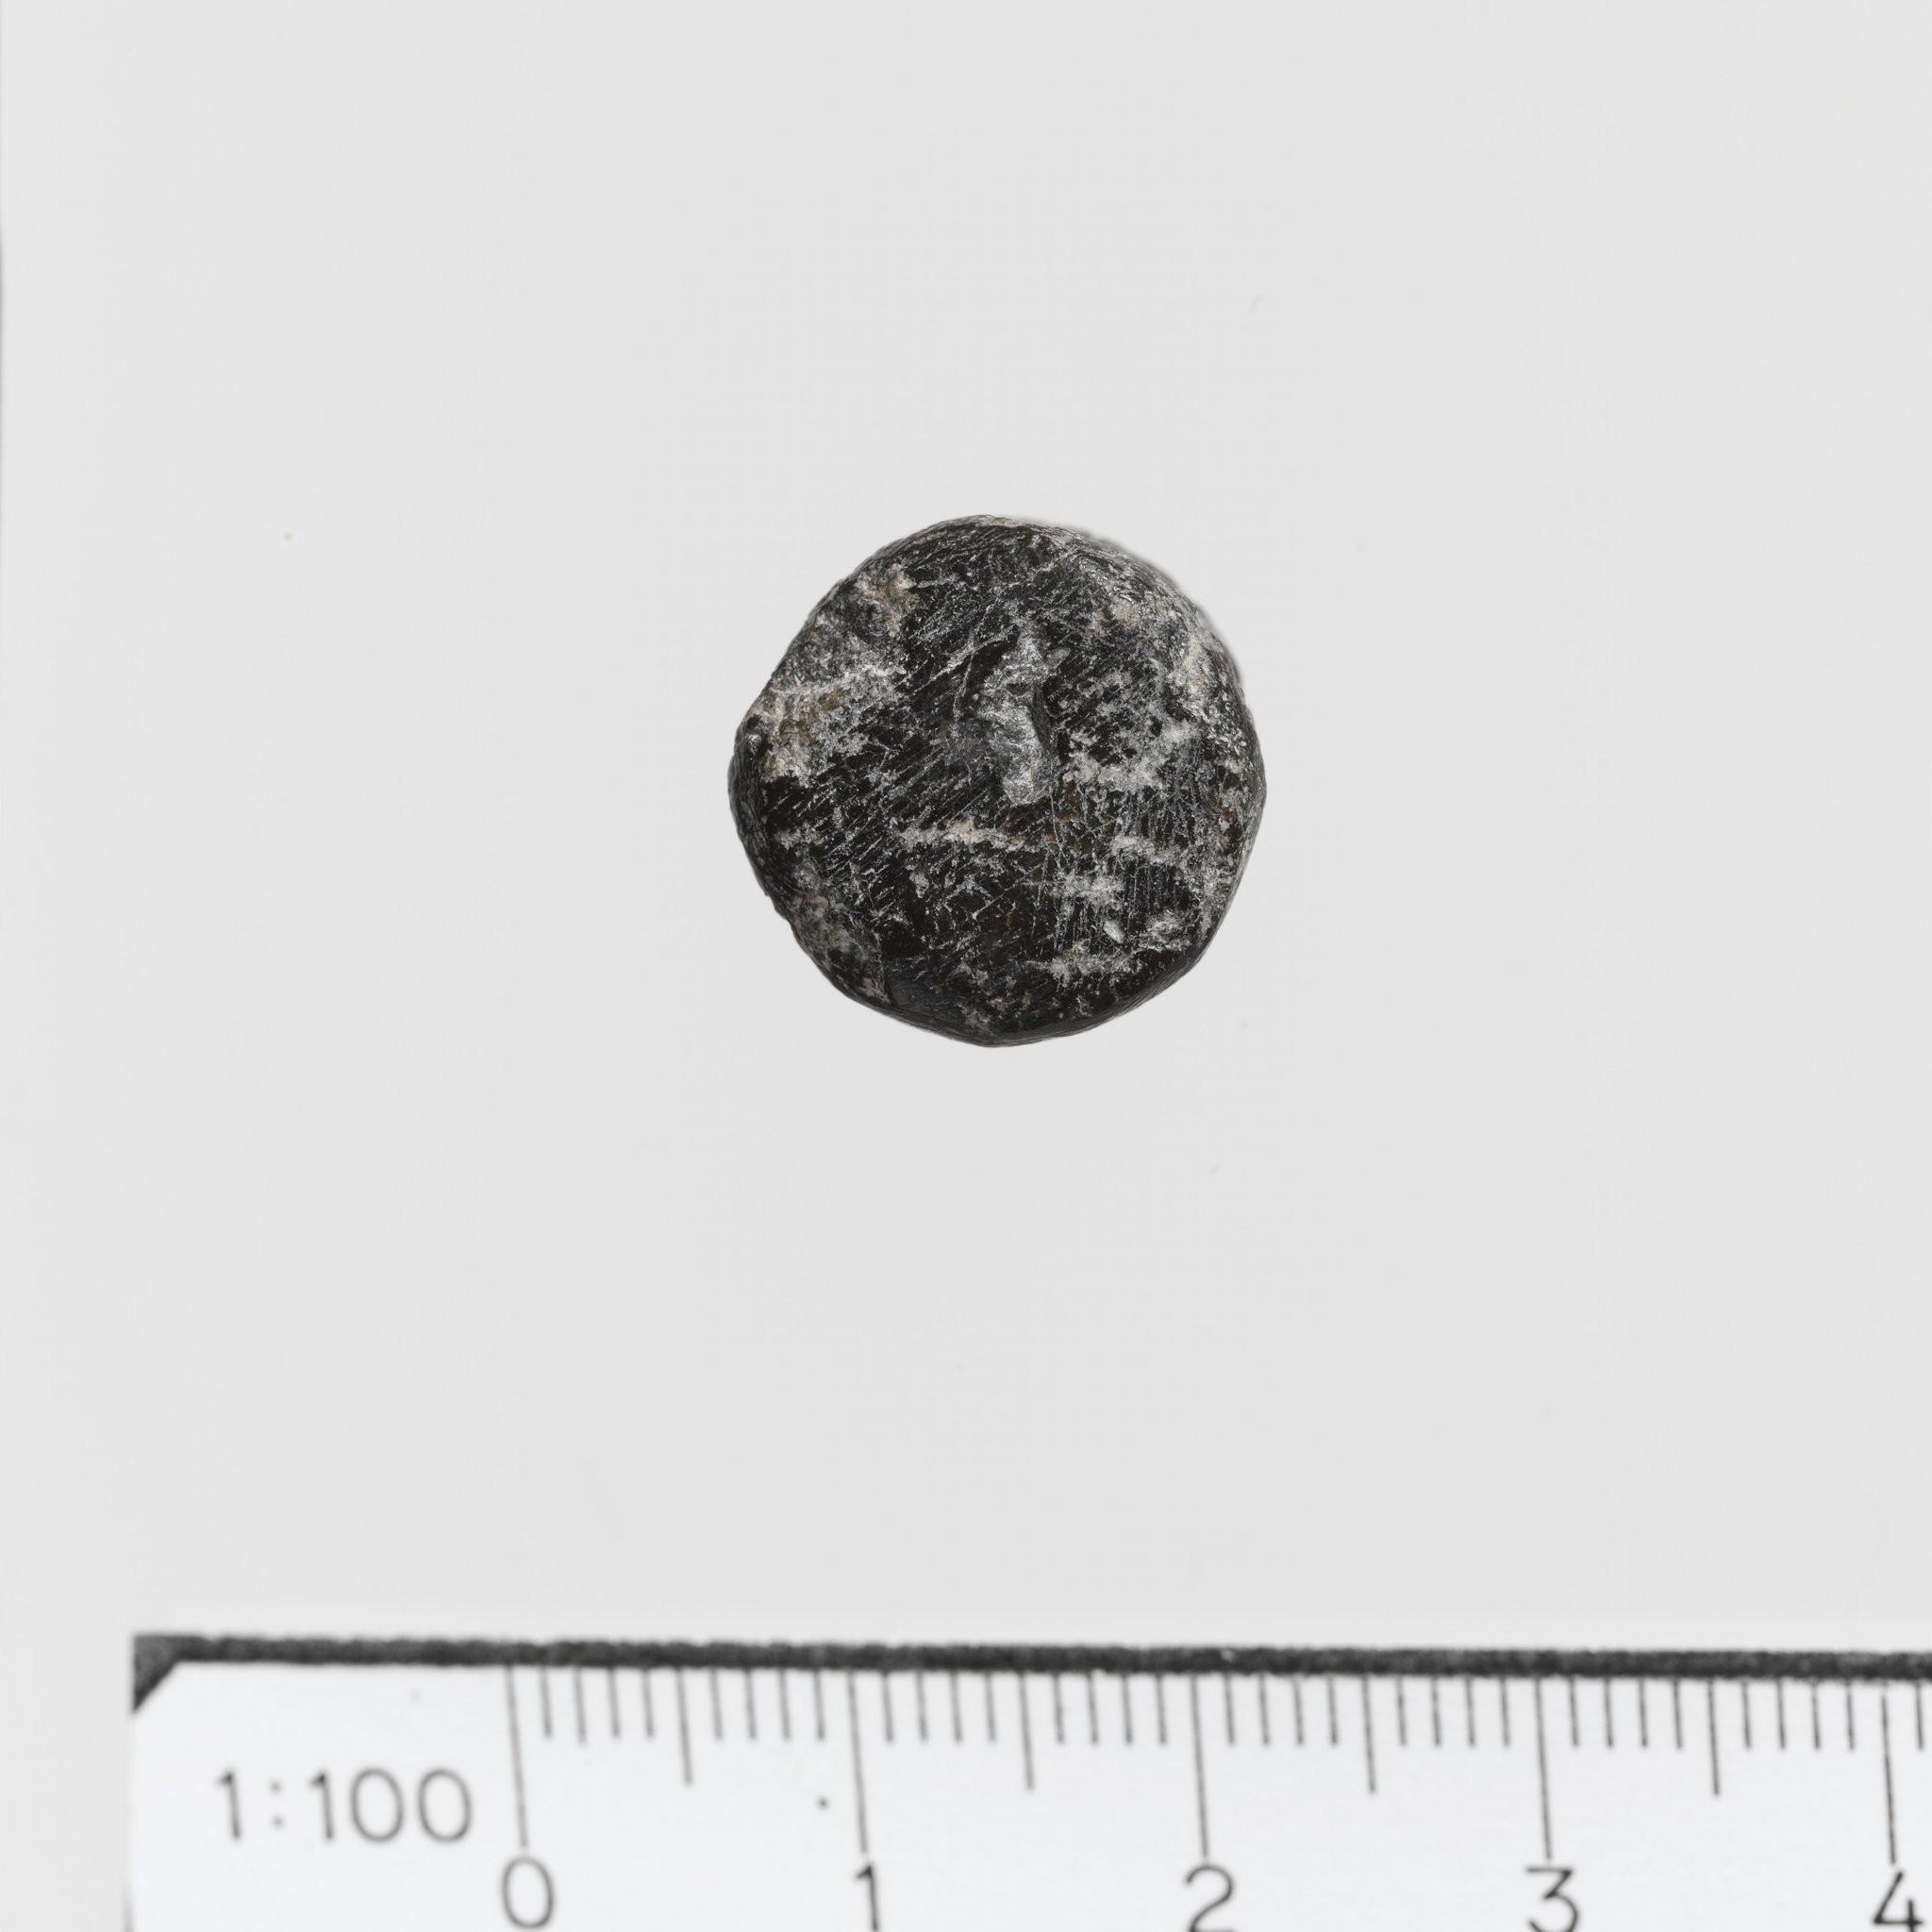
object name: seal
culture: minoan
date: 2600-2000 BCE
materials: stone